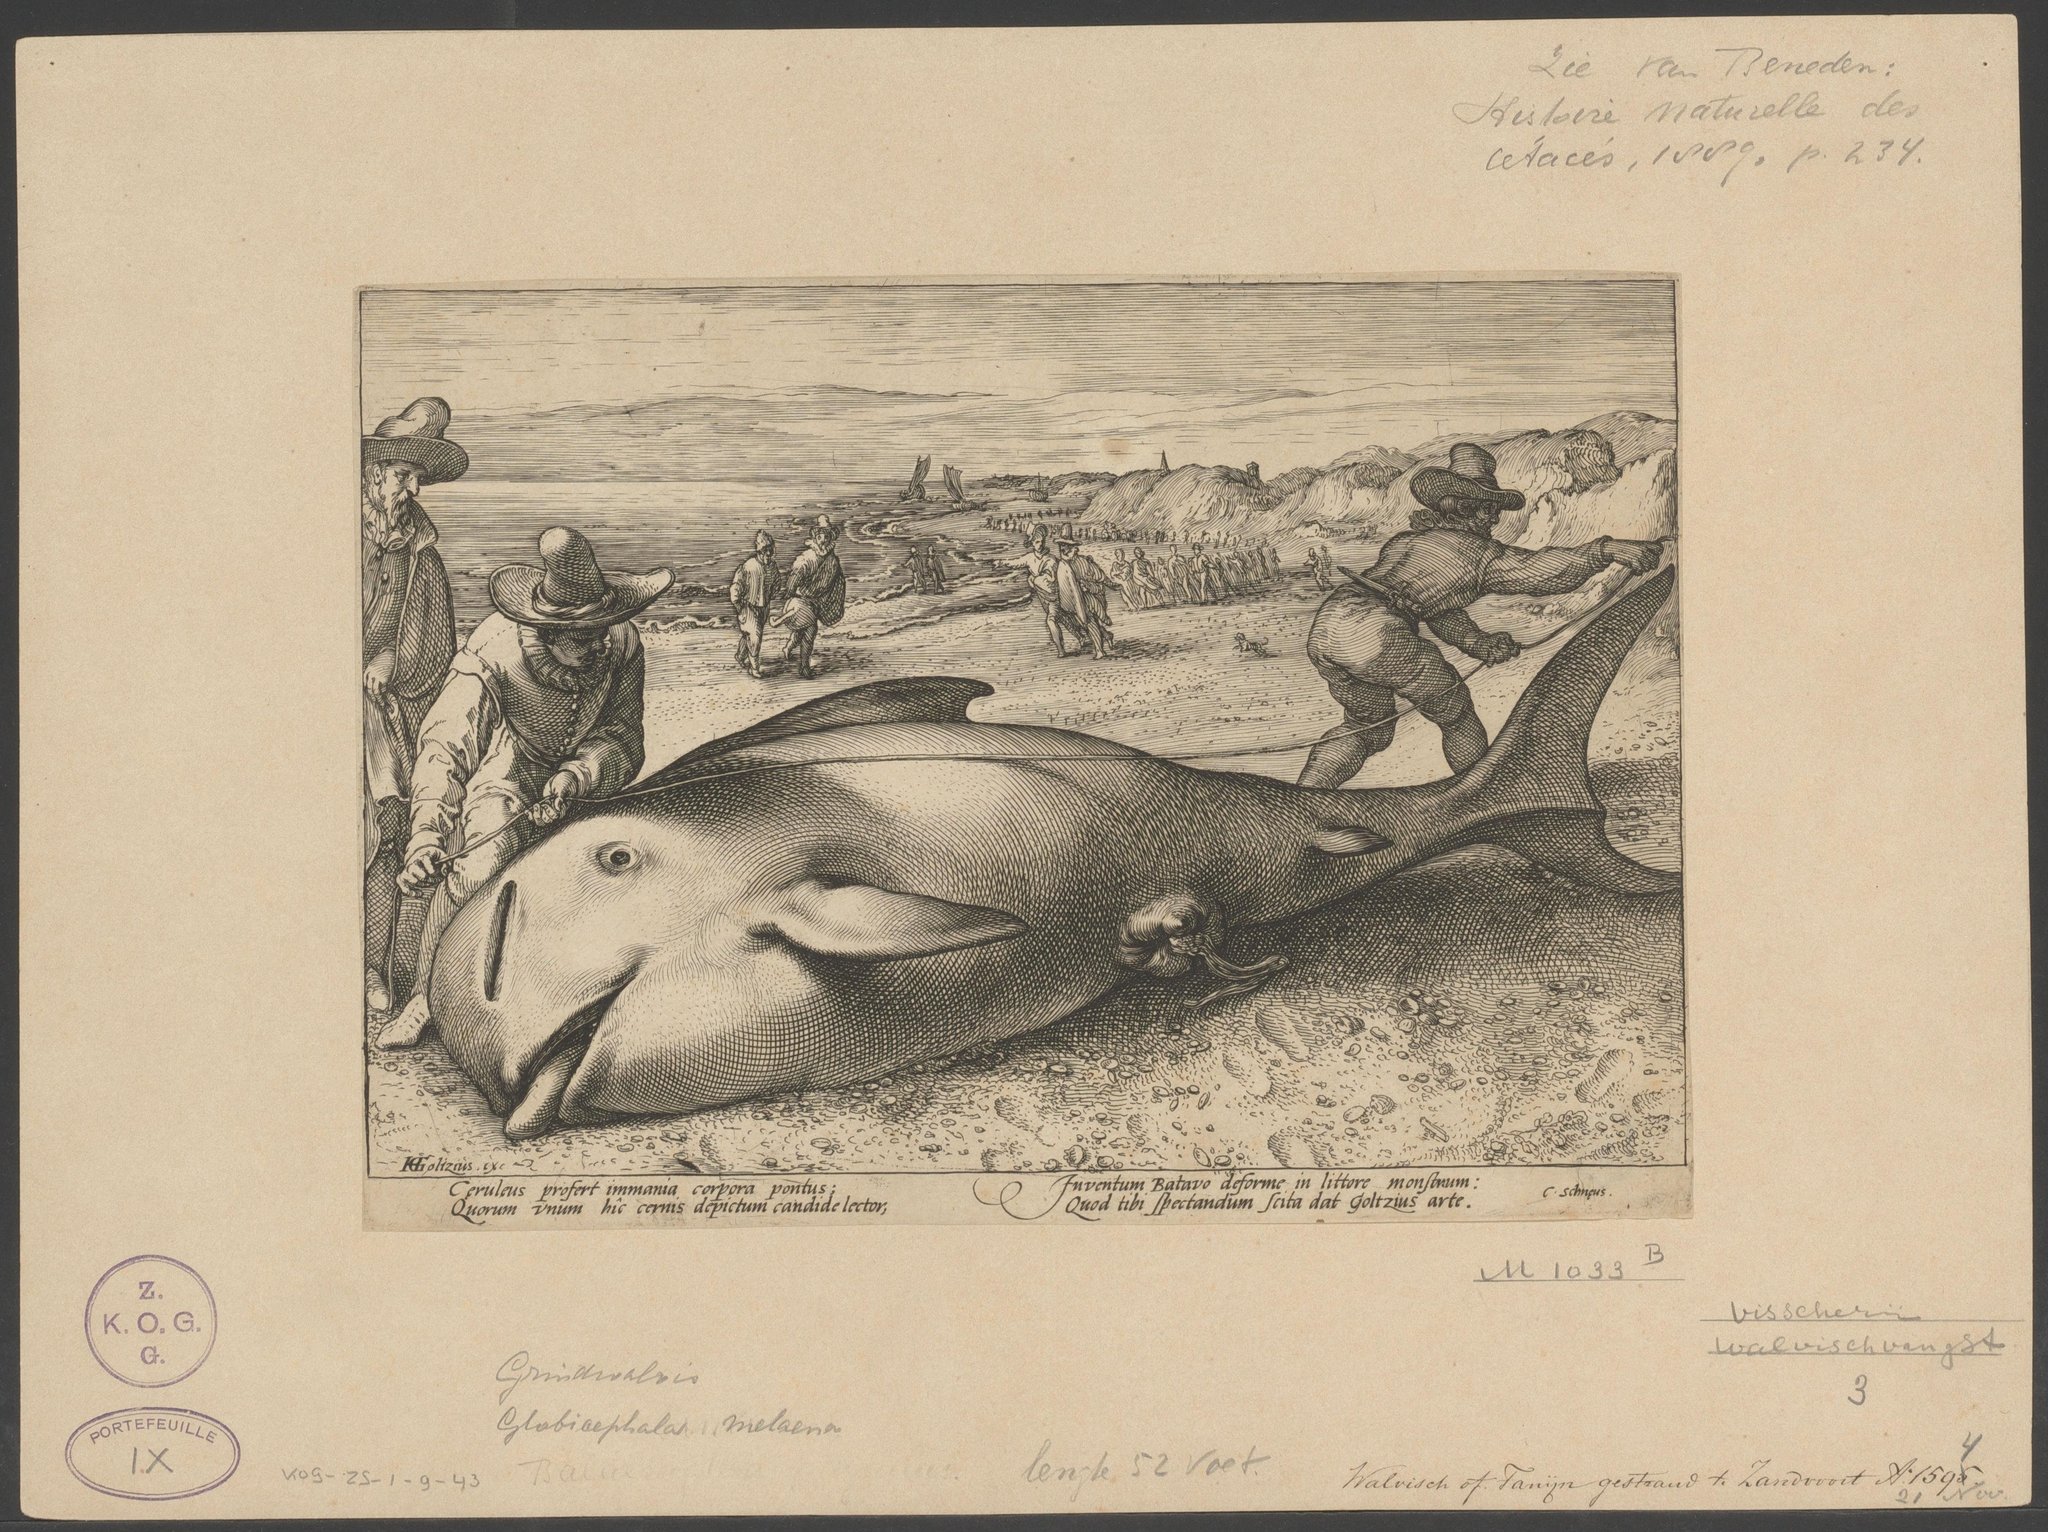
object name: print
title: Twee mannen meten een gestrande walvis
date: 1594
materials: paper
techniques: engraving, etching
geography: haarlem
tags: swimming mammals: whale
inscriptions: collector's mark: Lugt 1641, stamp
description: Twee mannen meten met een koord de lengte van een walvis of tonijn die op het strand ligt. Op de achtergrond komt een stoet mensen aangelopen. Onderaan een vierregelig vers in twee kolommen in het Latijn. Onderwerpsrubrieken binnen de Atlas Zeden en Gewoonten: Handel, nijverheid en verkeer, Visscherij, Walvischvangst.